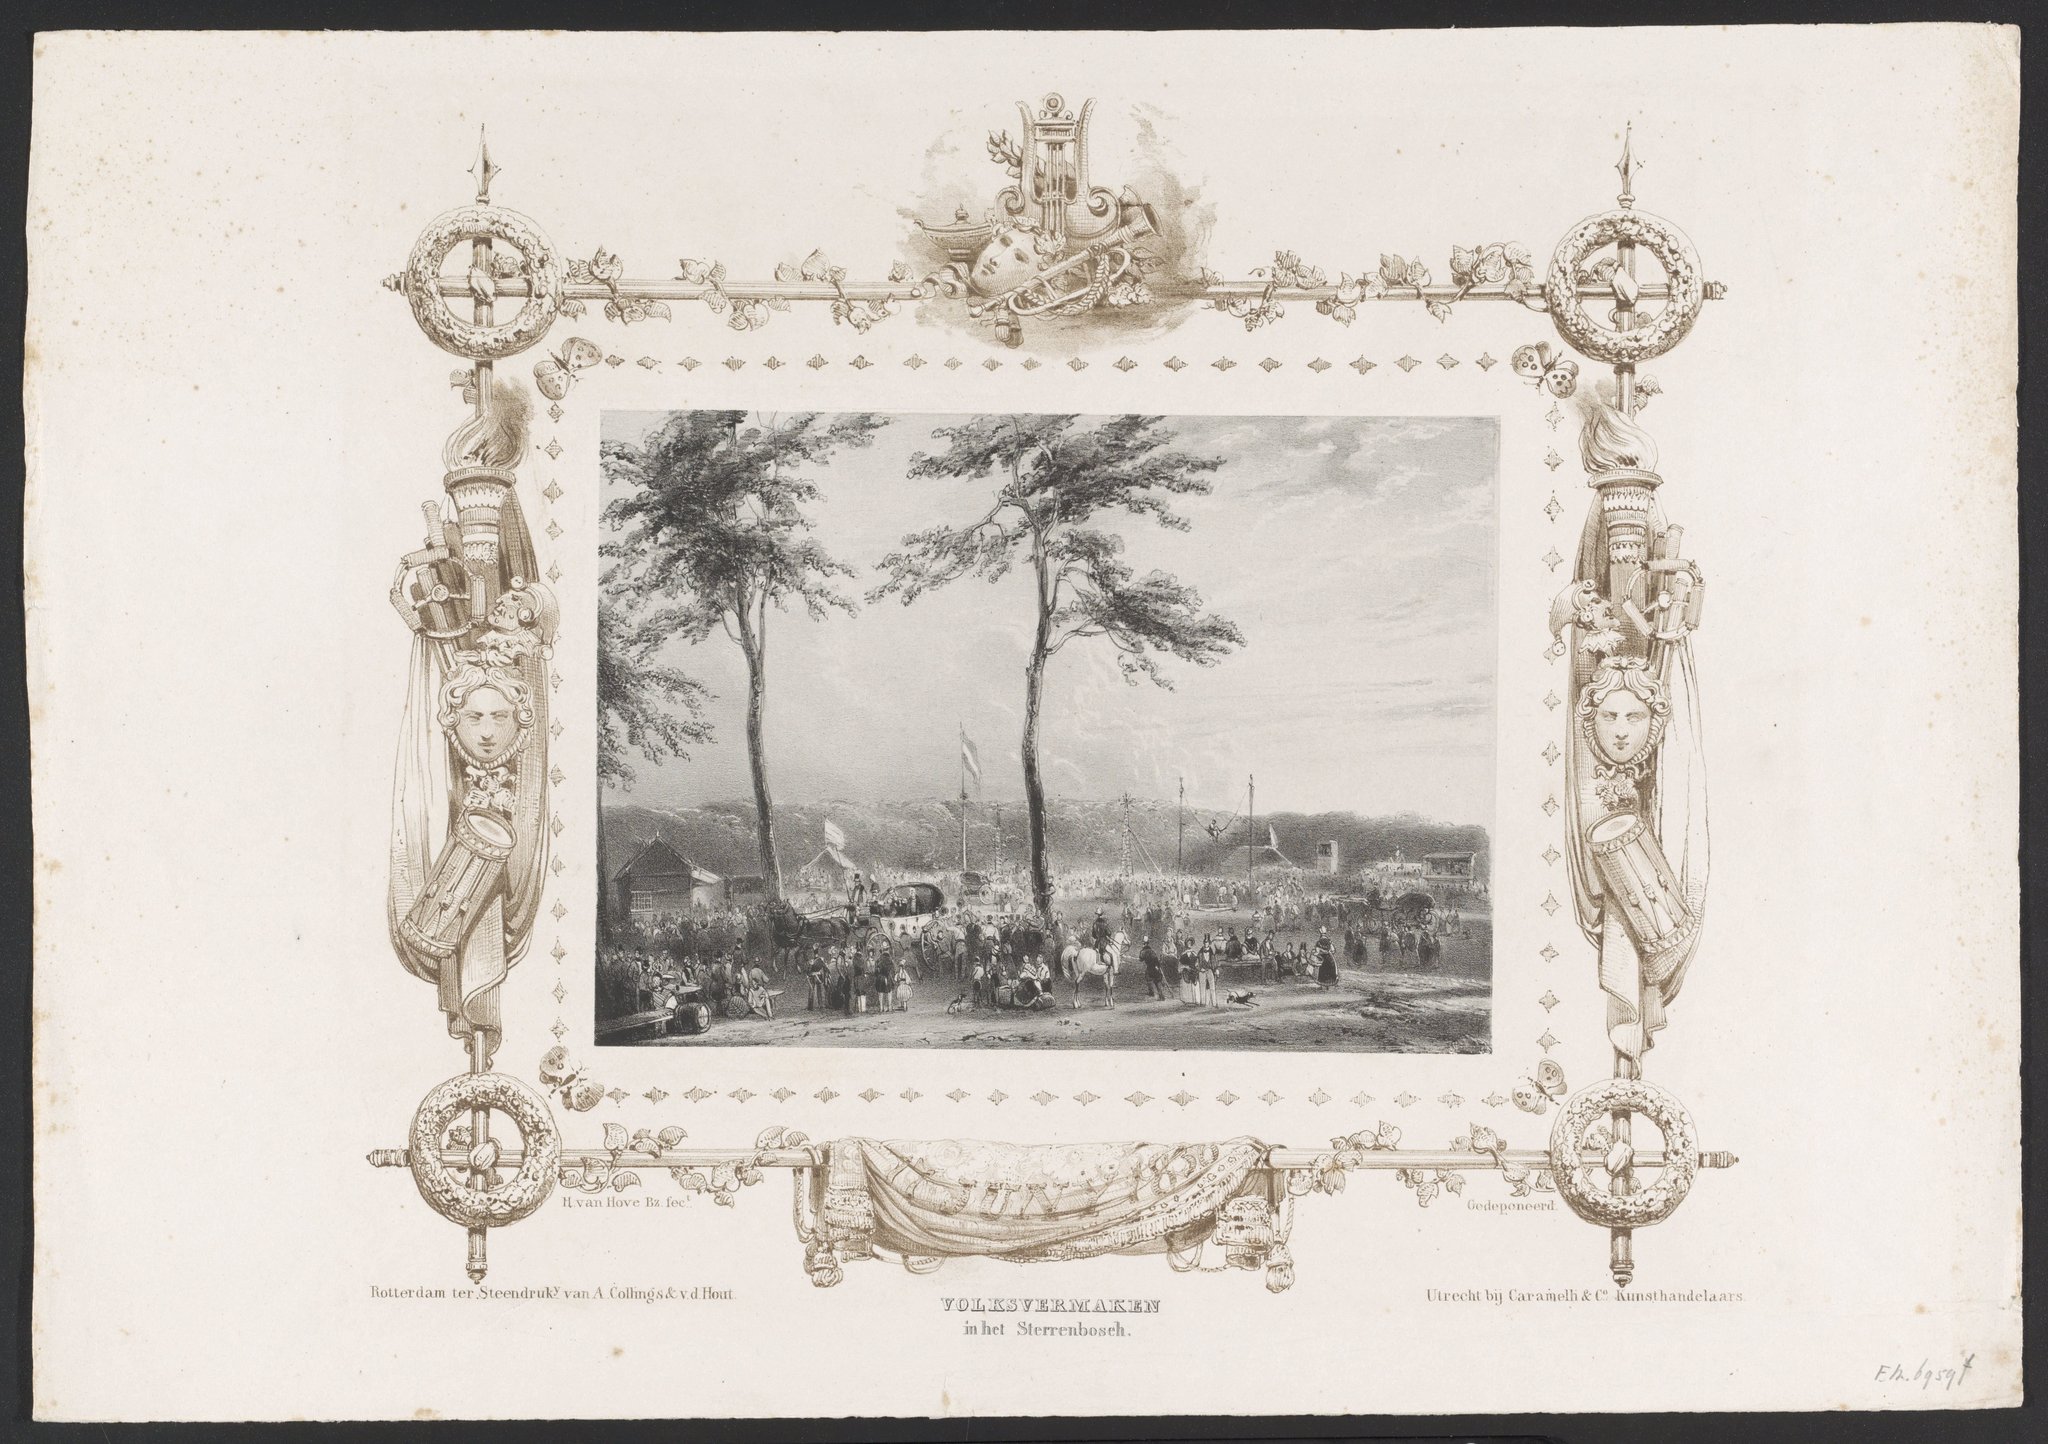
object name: print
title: Volksvermaken in het Sterrenbosch / 17 Junij 1836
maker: huib van hove bz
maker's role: painter, print maker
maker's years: 1814-1867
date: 1836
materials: paper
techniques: lithograph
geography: netherlands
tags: berlin, frederik (prins der nederlanden), pleasure fair and circus, commemoration of the founding of a university, utrecht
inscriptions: : ‘Gedeponeerd’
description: Kermis en andere vormen van vermaak gehouden op de open vlakte van het Sterrenbos, 17 juni 1836. Links op de voorgrond prins Frederik in een open rijtuig. Binnen een gekleurde decoratieve kader met maskers, poppen en trommels. Onderdeel van de serie van zes ongenummerde platen van de feestelijkheden bij de viering van het tweede eeuwfeest (1636-1836) van de Utrechtsche Hogeschool, 12-17 juni 1836.